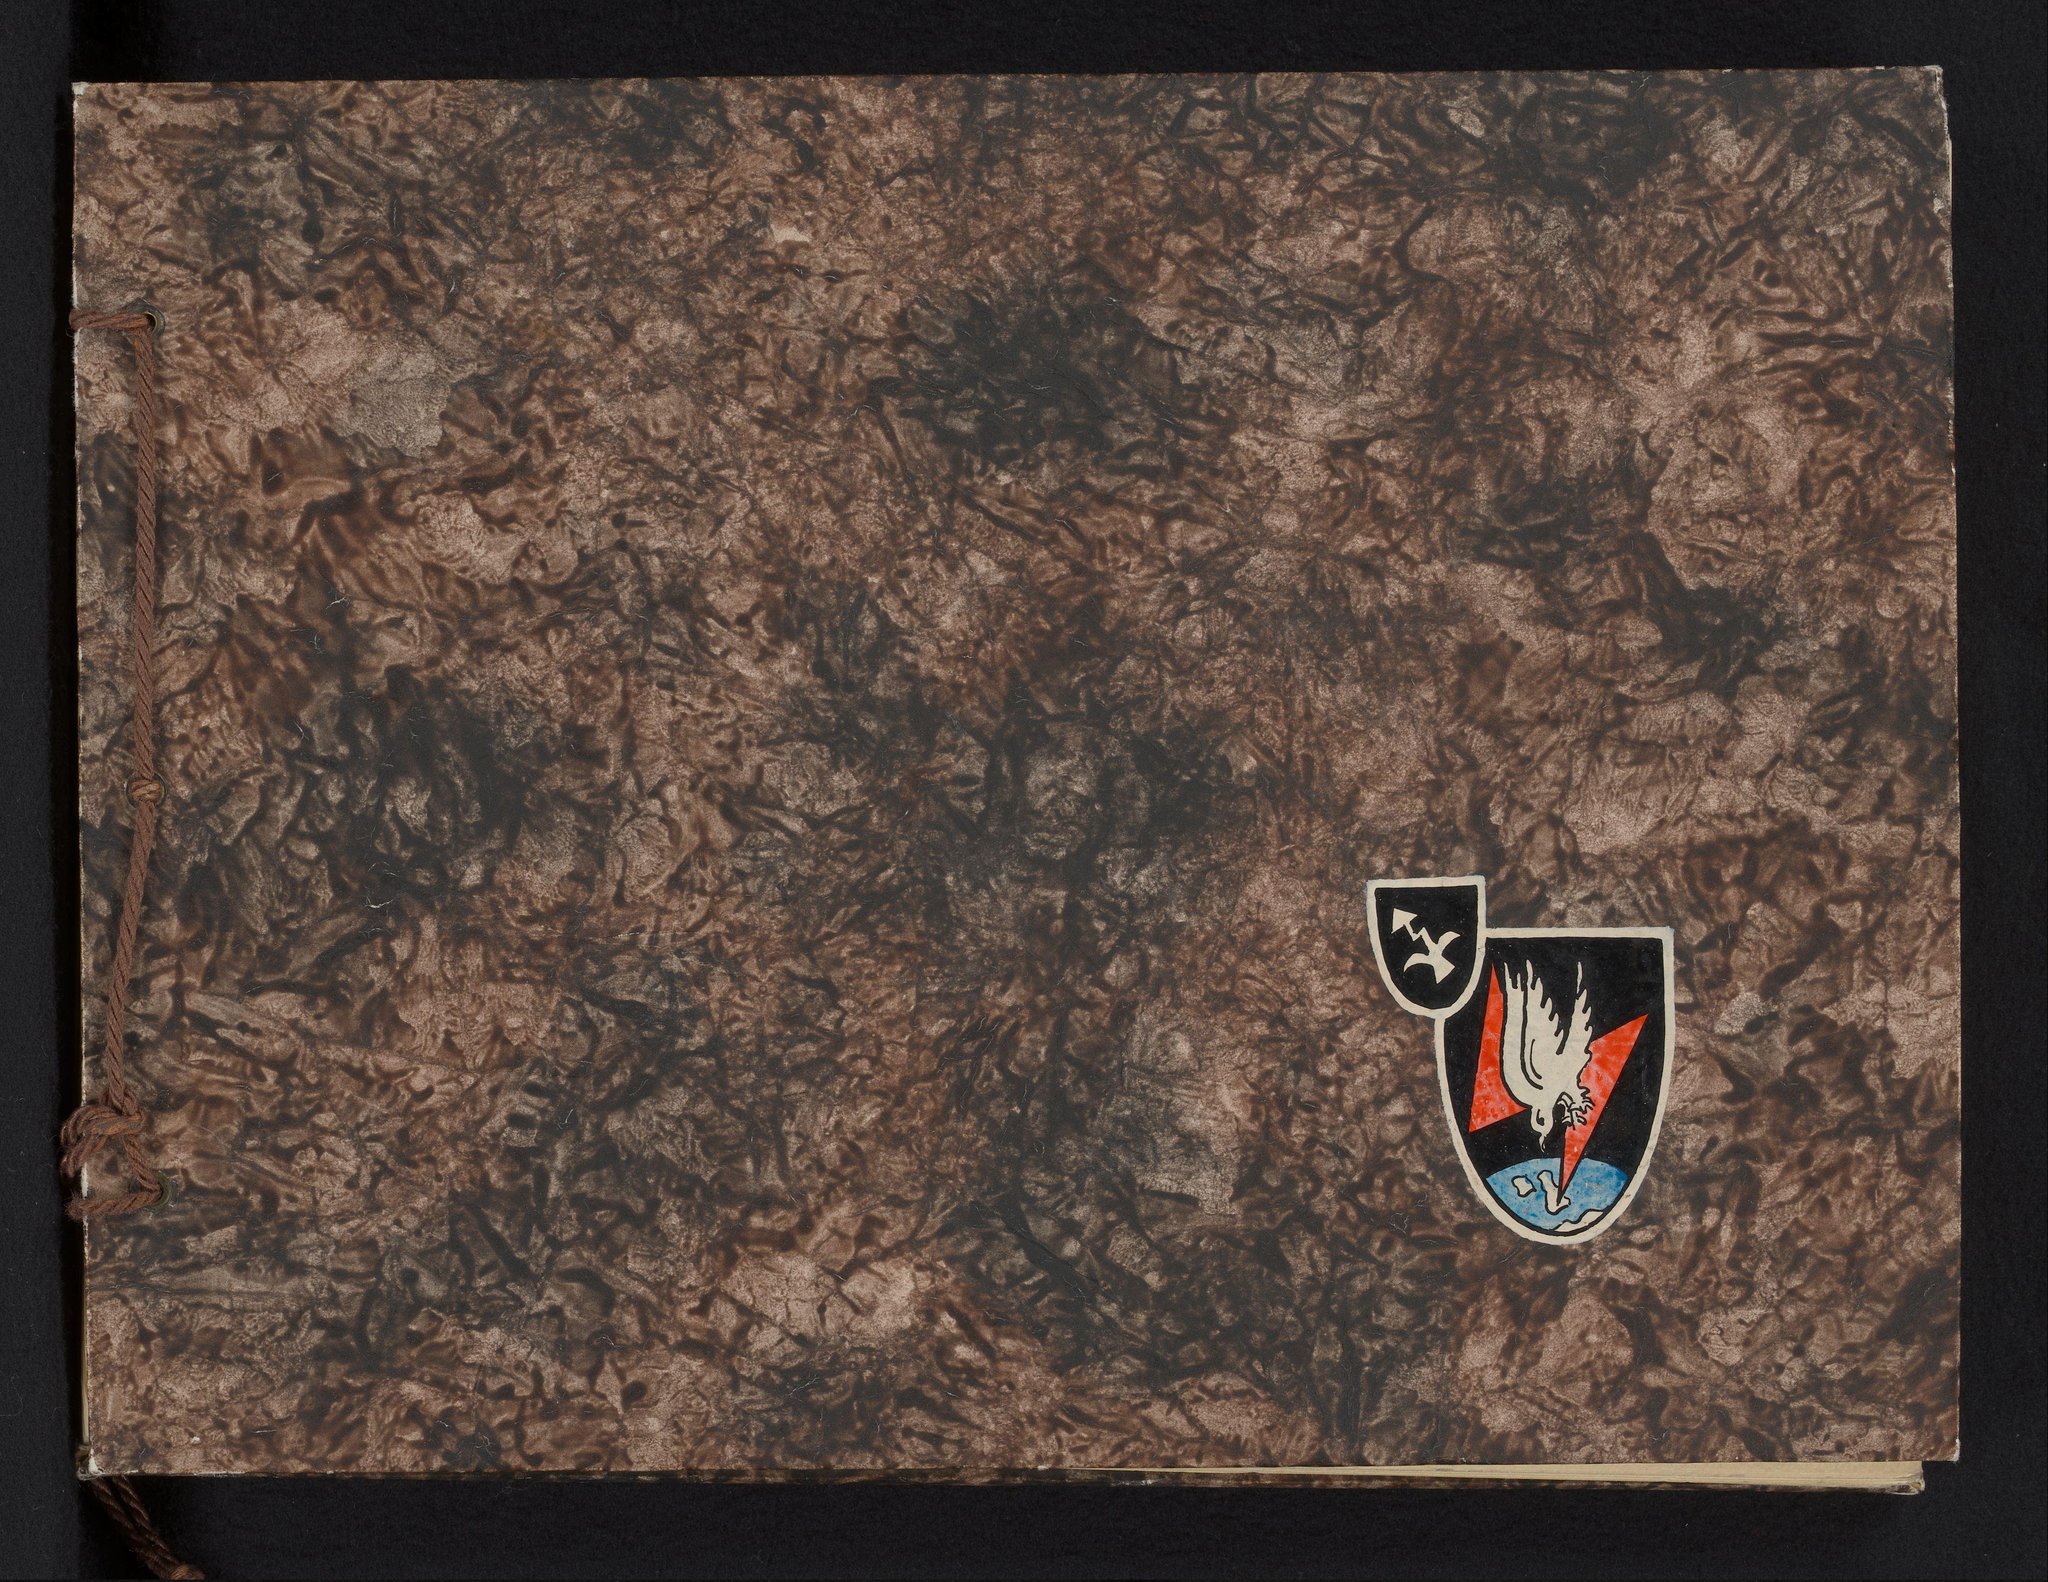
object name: photograph album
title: Die 4./ Ln. Rgt. 211 besteht ein Jahr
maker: Anonymous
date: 1942-1943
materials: cardboard, paper, photographic support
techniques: drawing, gelatin silver print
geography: germany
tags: luftnachrichten-regiment 211, breda, tweede wereldoorlog, bezetting van nederland, kerst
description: Duits militair fotoalbum uit de Tweede Wereldoorlog met een kartonnen omslag bekleed met bruin gemarmerd papier. Op de buitenzijde is het embleem van Luftnachrichten-Regiment geplakt. In het album 29 crèmekleurige kartonnen binnenbladen, met een bruin koord in omslag gebonden. Het binnenwerk is voorzien van 135 zwart-wit foto's met gestencilde teksten op tussenbladen met uitleg over de foto's van personen (met namen) en werkzaamheden, soms met kleine tekeningen. Foto's van de kloosterkazerne in Breda waar de 4e compagnie van dit regiment gelegerd was, de officieren, diverse militaire activiteiten, vrijetijdsbesteding en Kerstviering 1942. Sommige opnamen betreffen de Eifel, Venlo en Gilze-Rijen.